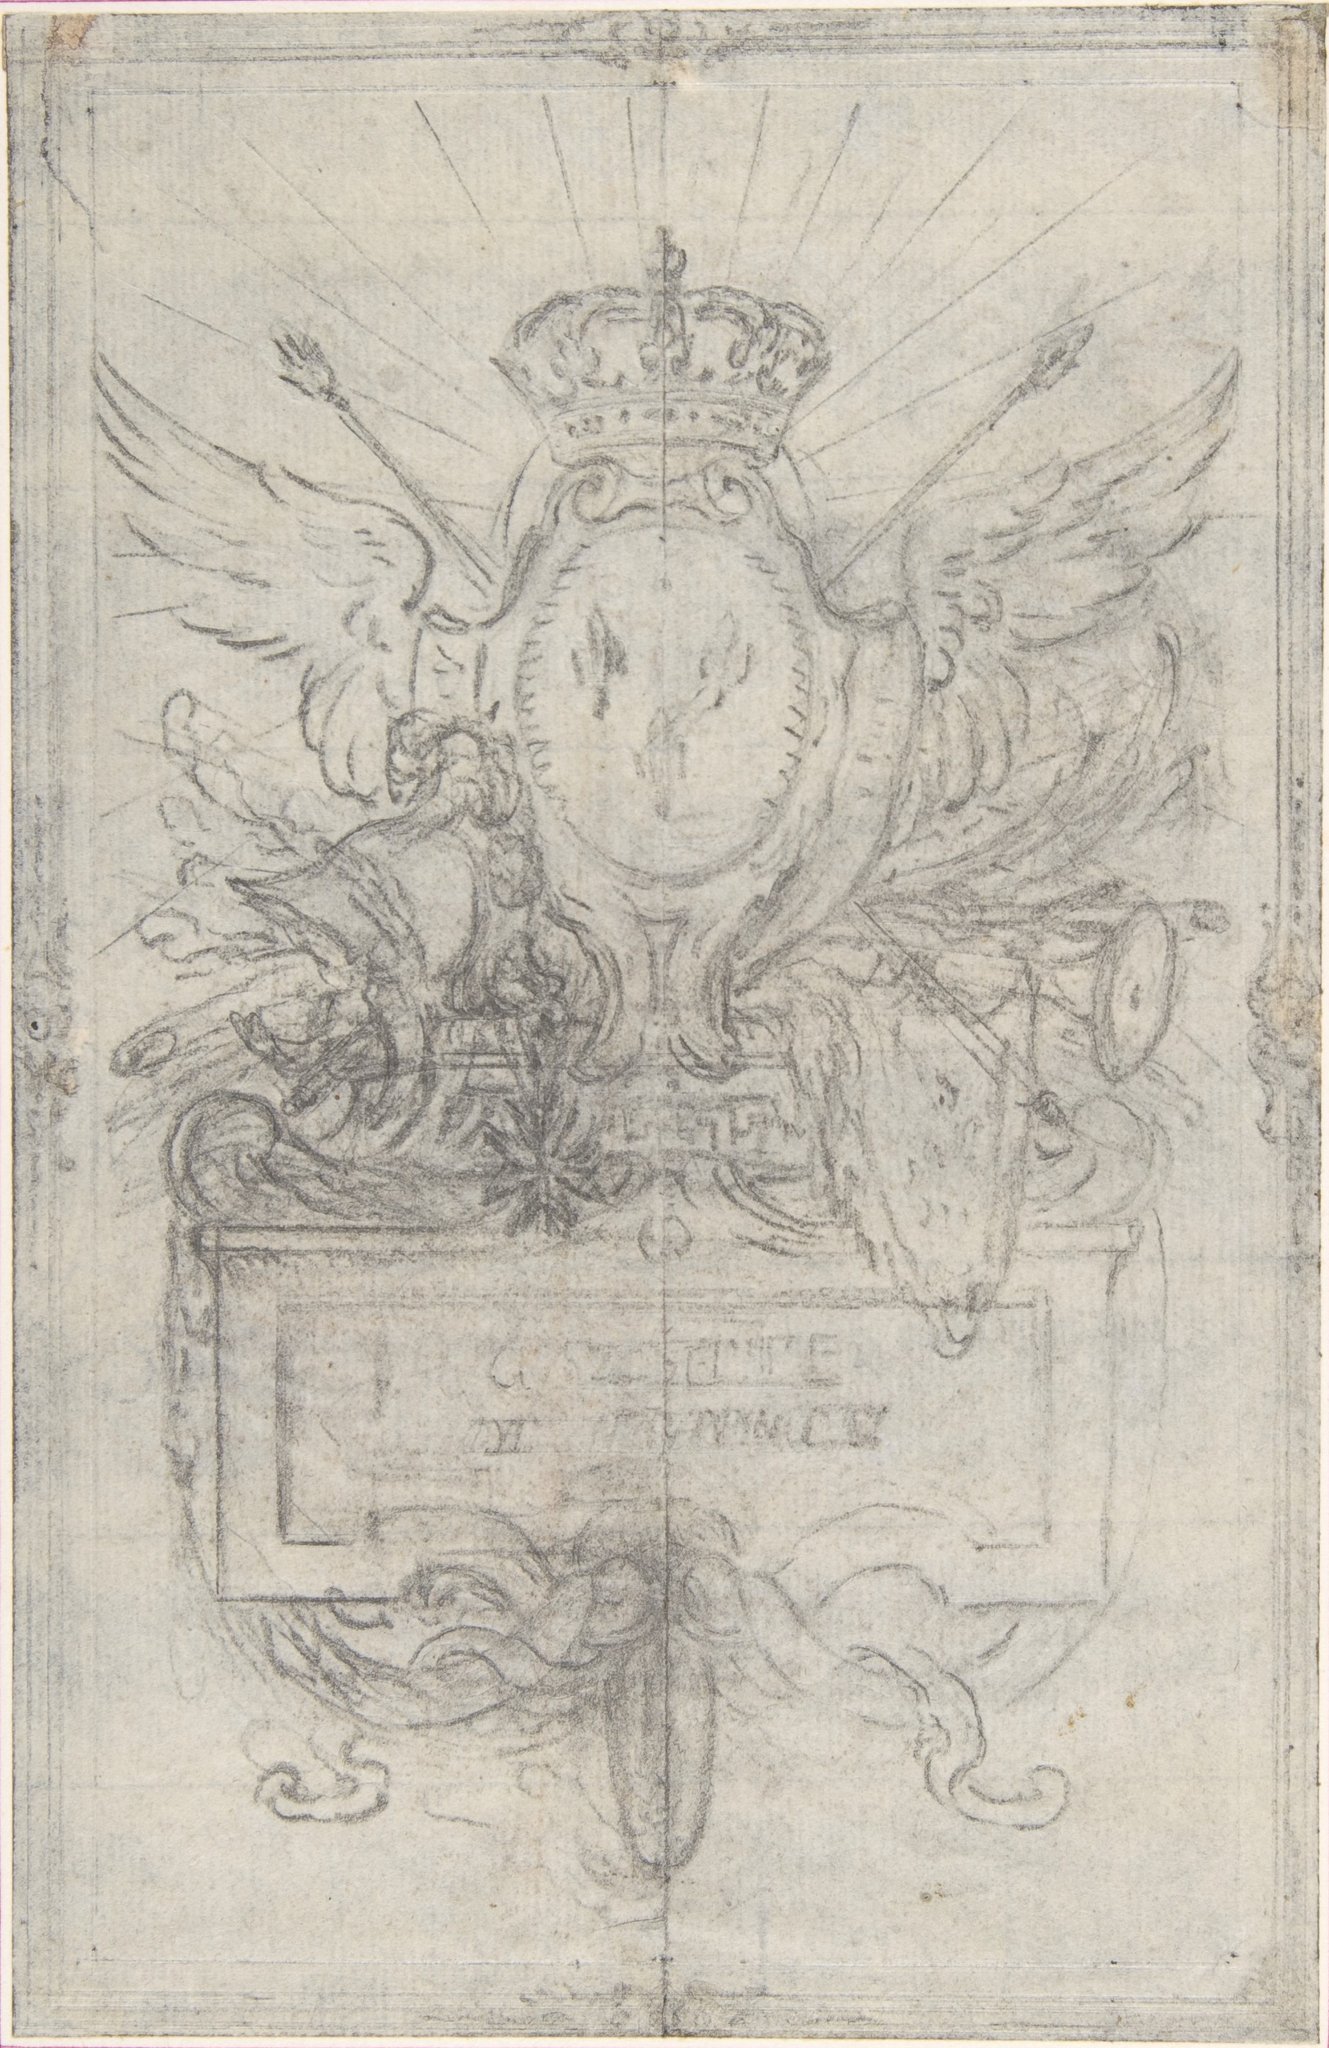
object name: drawing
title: Design for the Headpiece of the "Gazette de France"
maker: hubert françois gravelot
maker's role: artist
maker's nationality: french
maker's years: 1699-1773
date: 1701-1800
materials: chalk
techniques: incising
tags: coat of arms